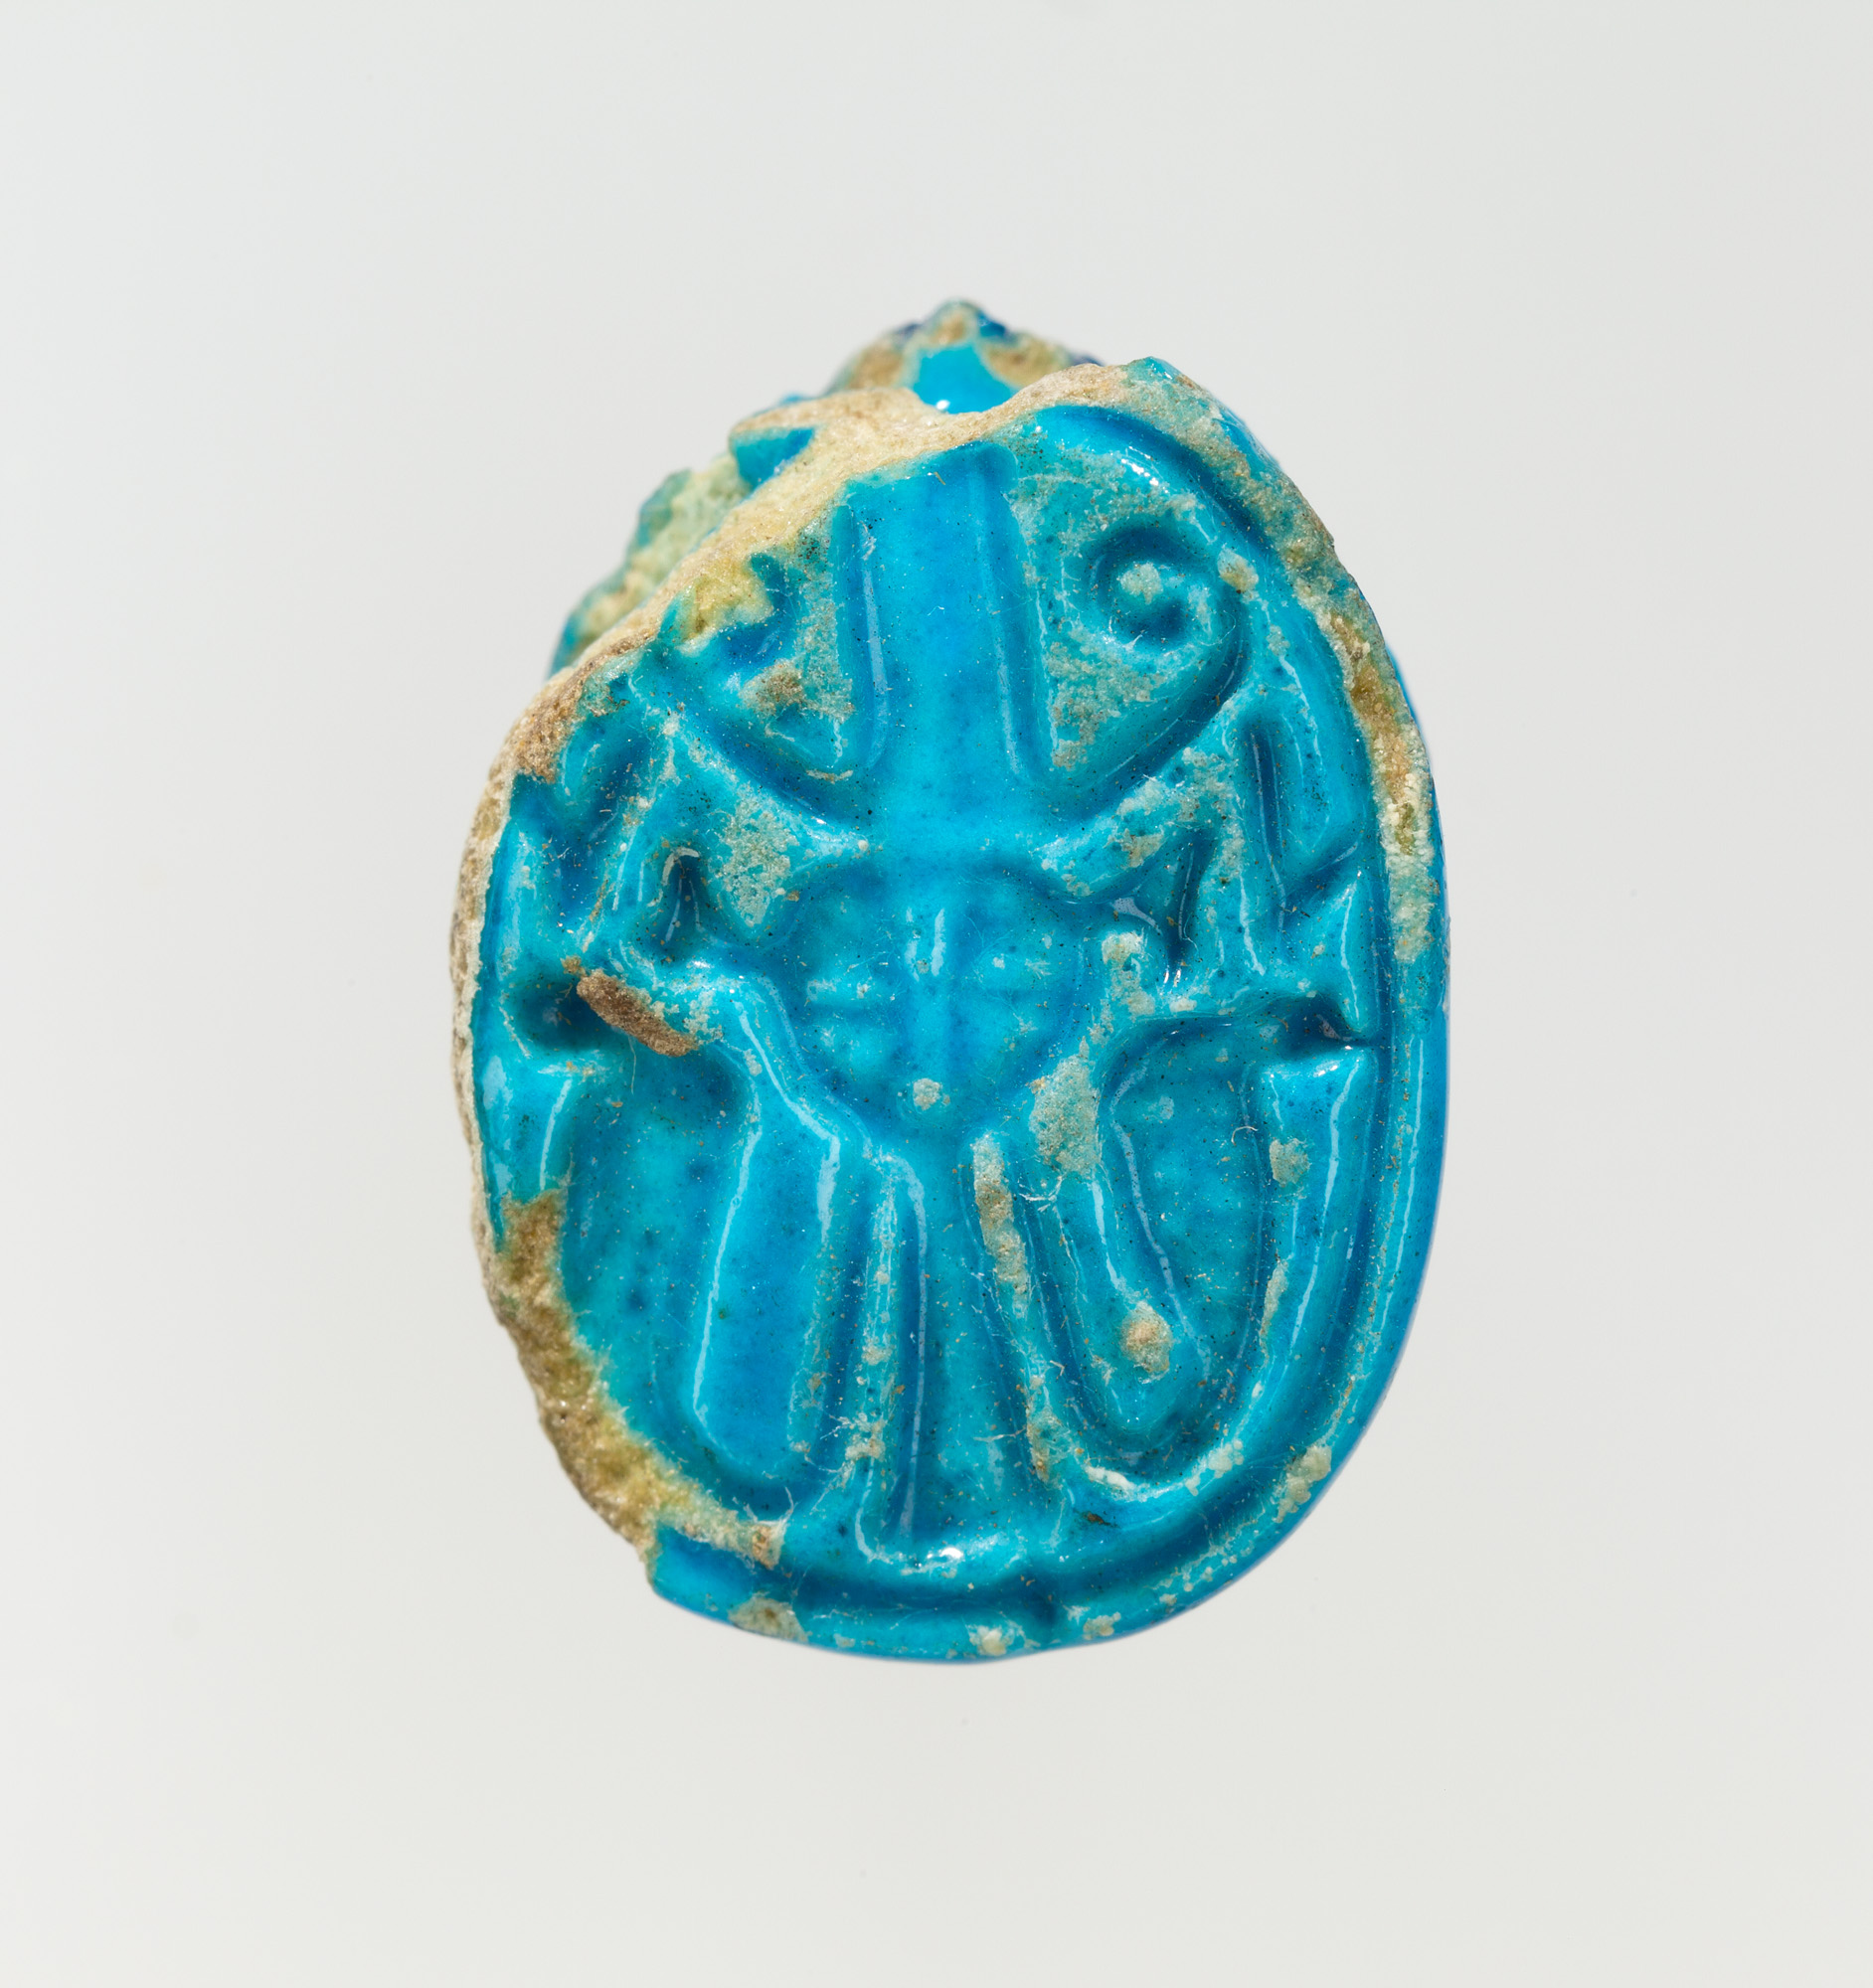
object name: scarab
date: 1479-1458 BCE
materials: faience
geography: egypt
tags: scarabs